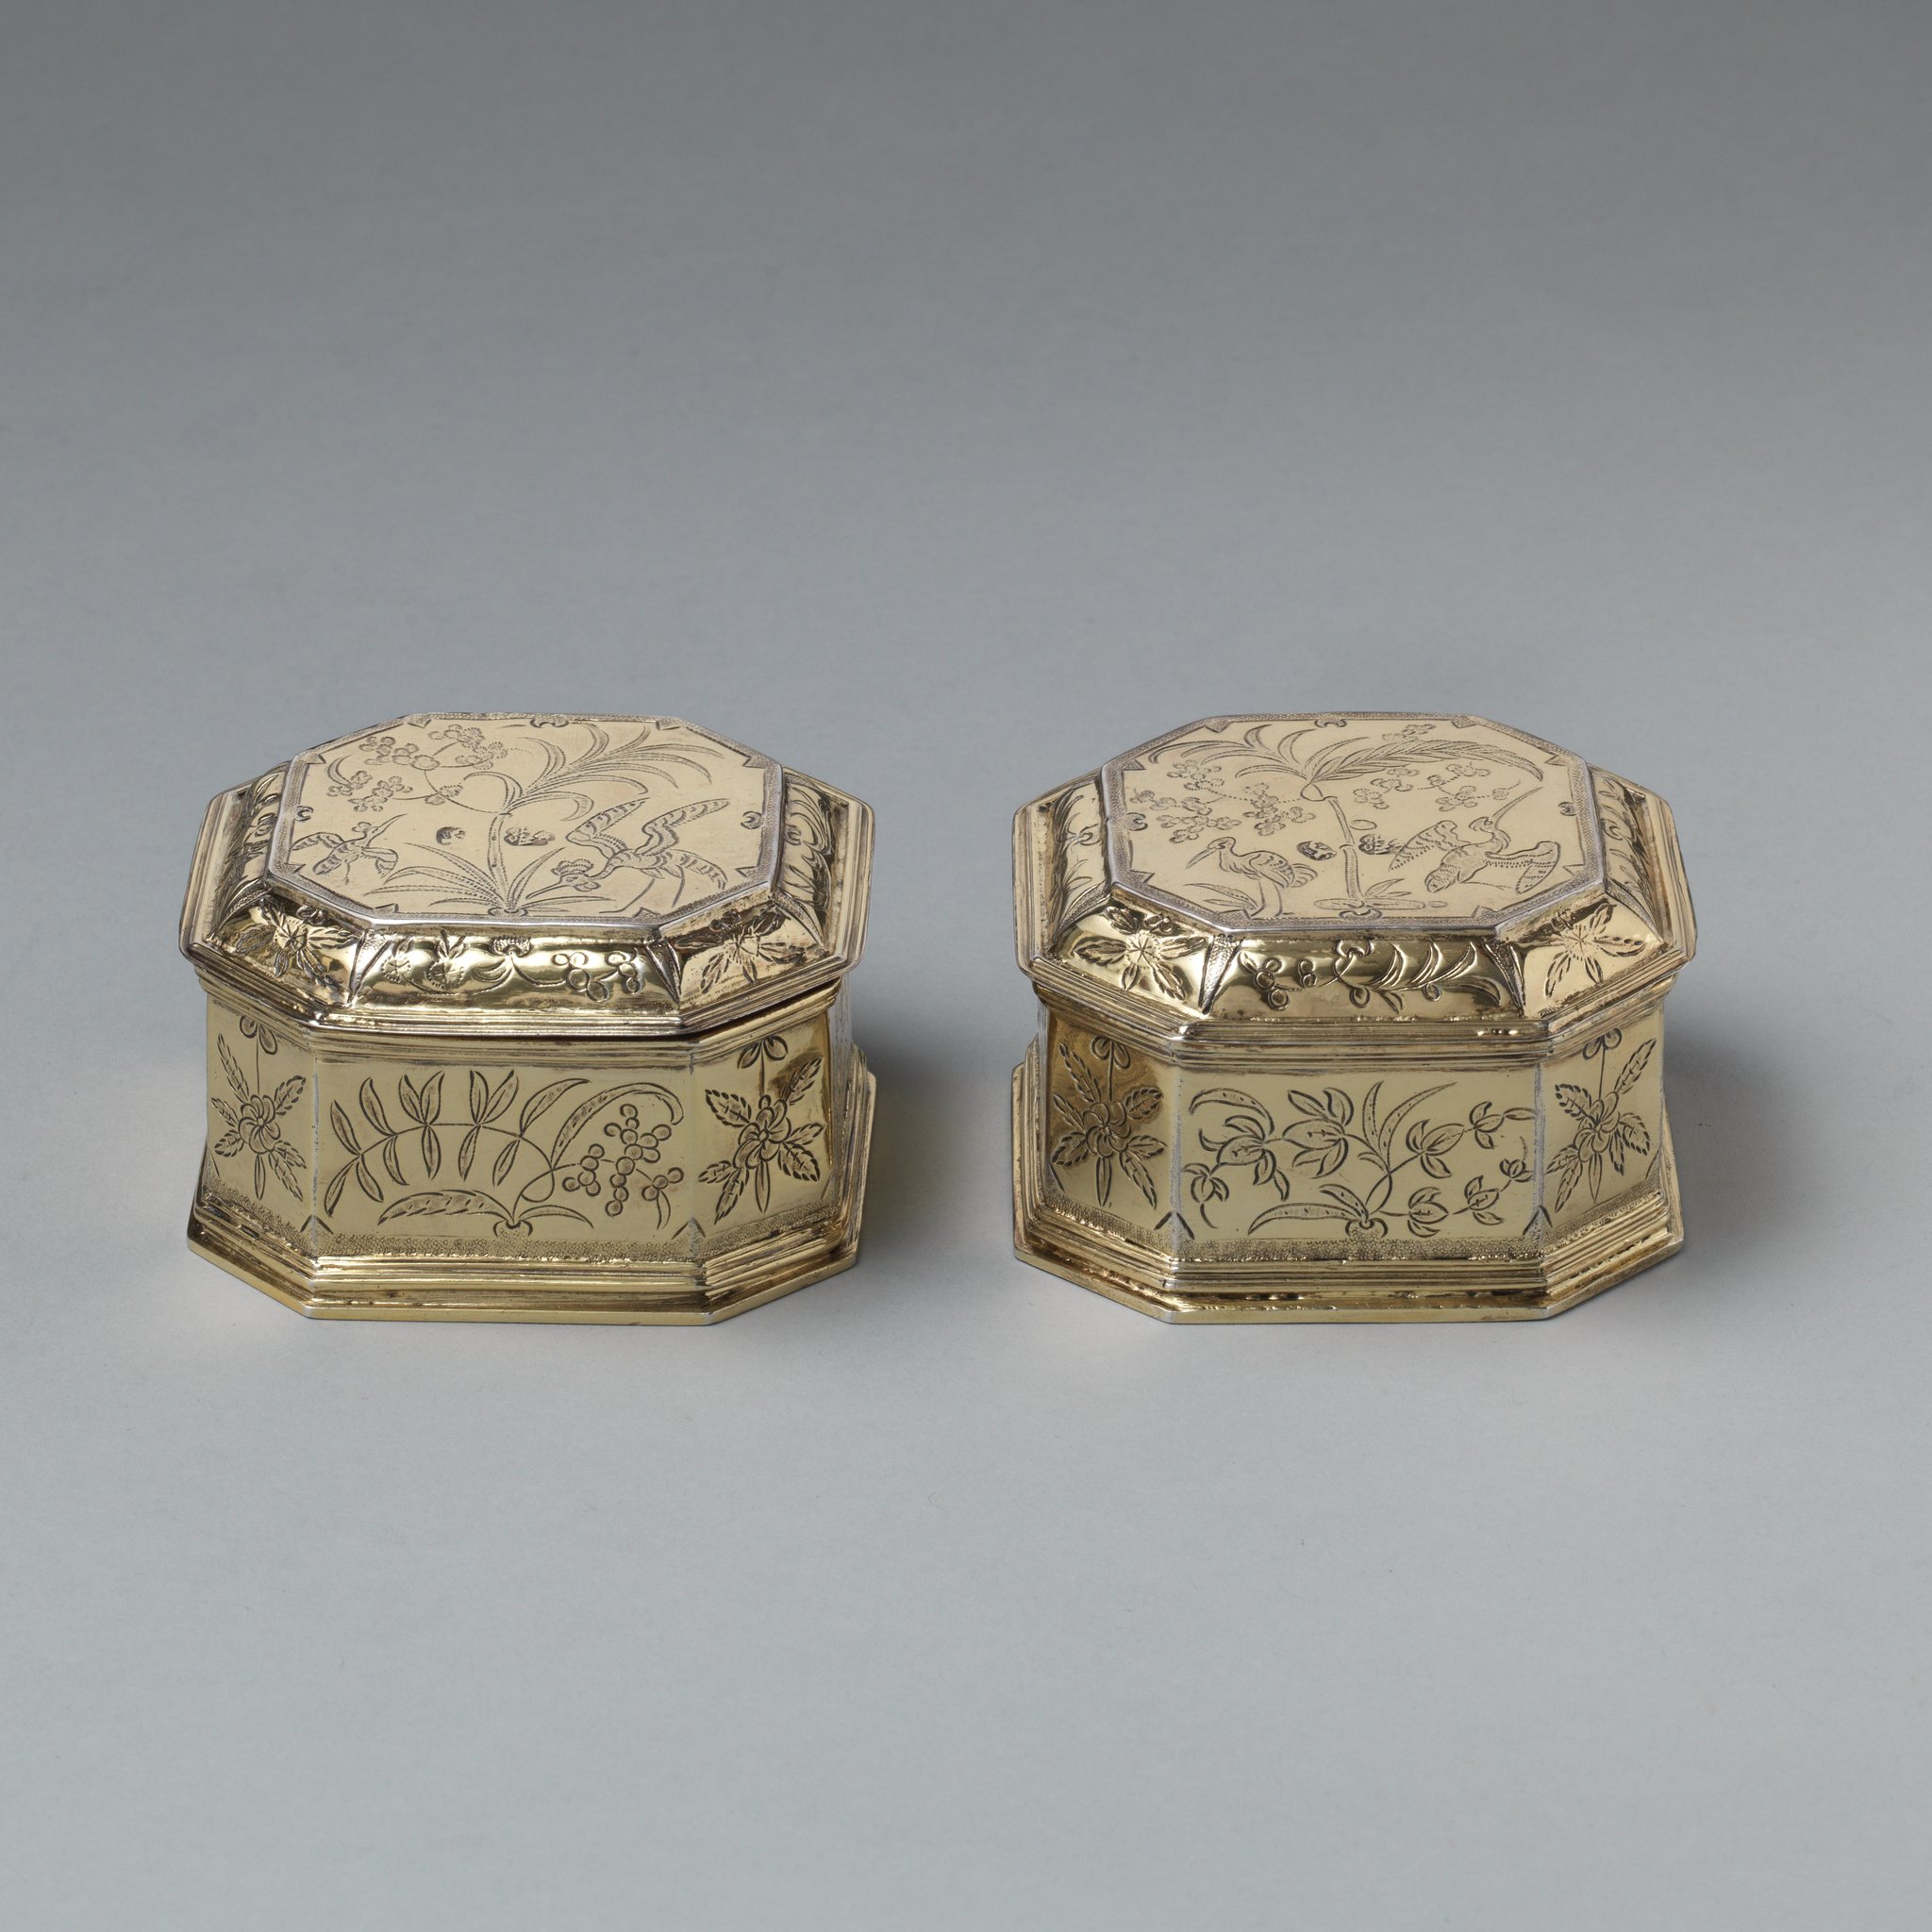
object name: box with cover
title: Pair of boxes with covers (part of a toilet service)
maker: william fowle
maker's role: maker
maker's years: 1658-1684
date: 1683-1684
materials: silver gilt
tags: birds,flowers